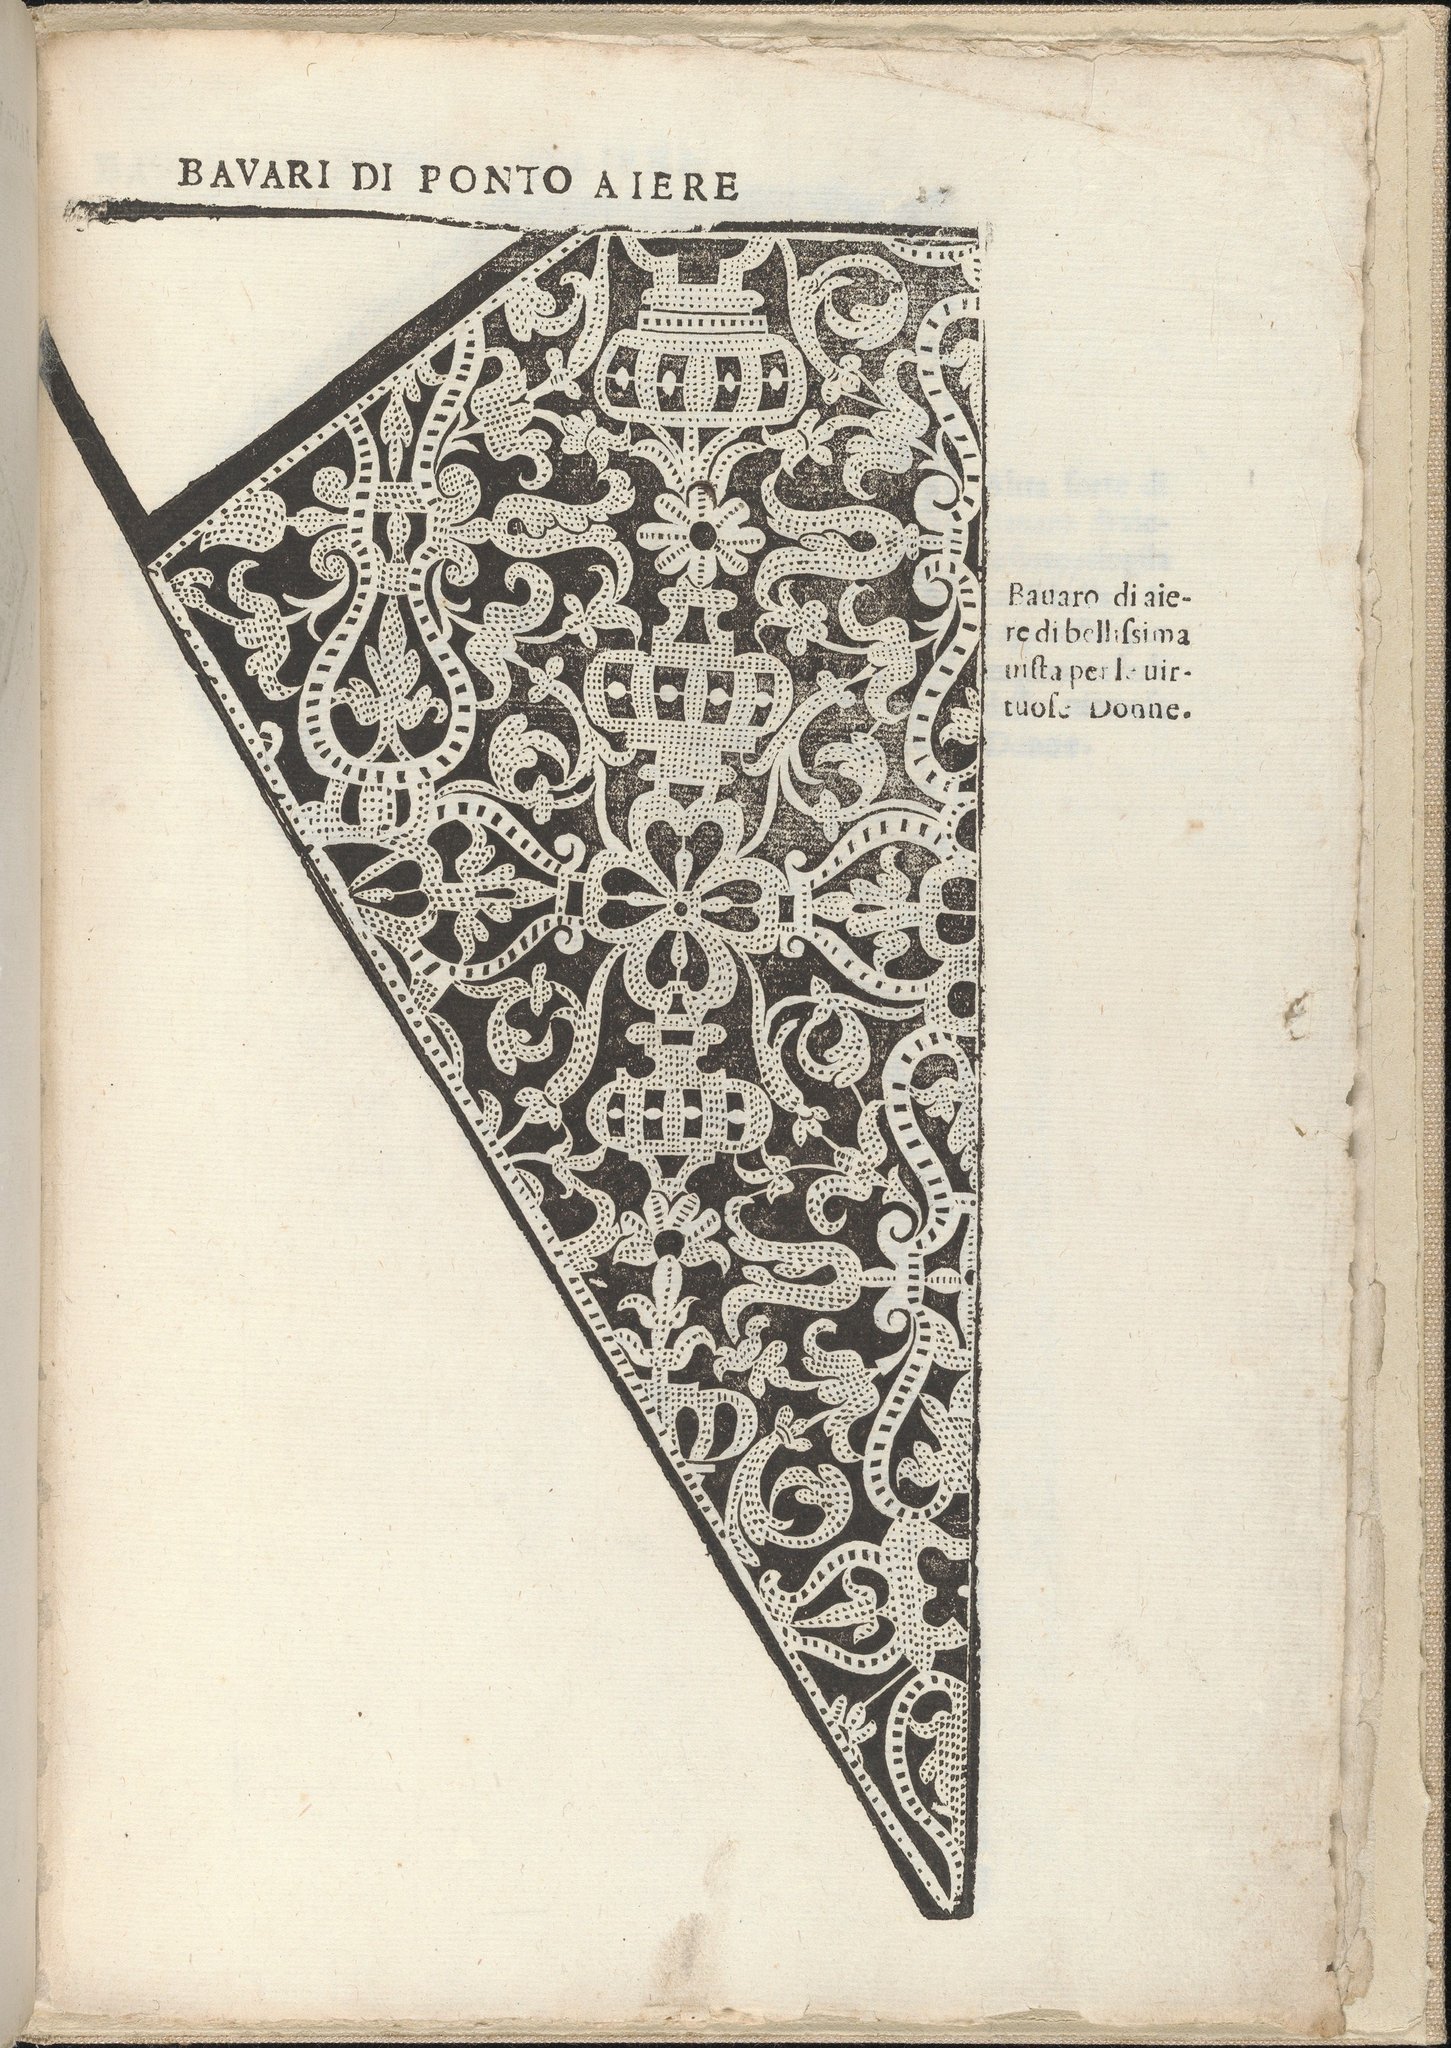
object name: book print ornament architecture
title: Ornamento nobile...Fatta da Lucretia Romana (Libro V of the Corona), page 13 (recto)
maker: cesare vecellio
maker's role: author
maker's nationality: italian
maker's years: 1521-1601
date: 1620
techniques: woodcut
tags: ornament